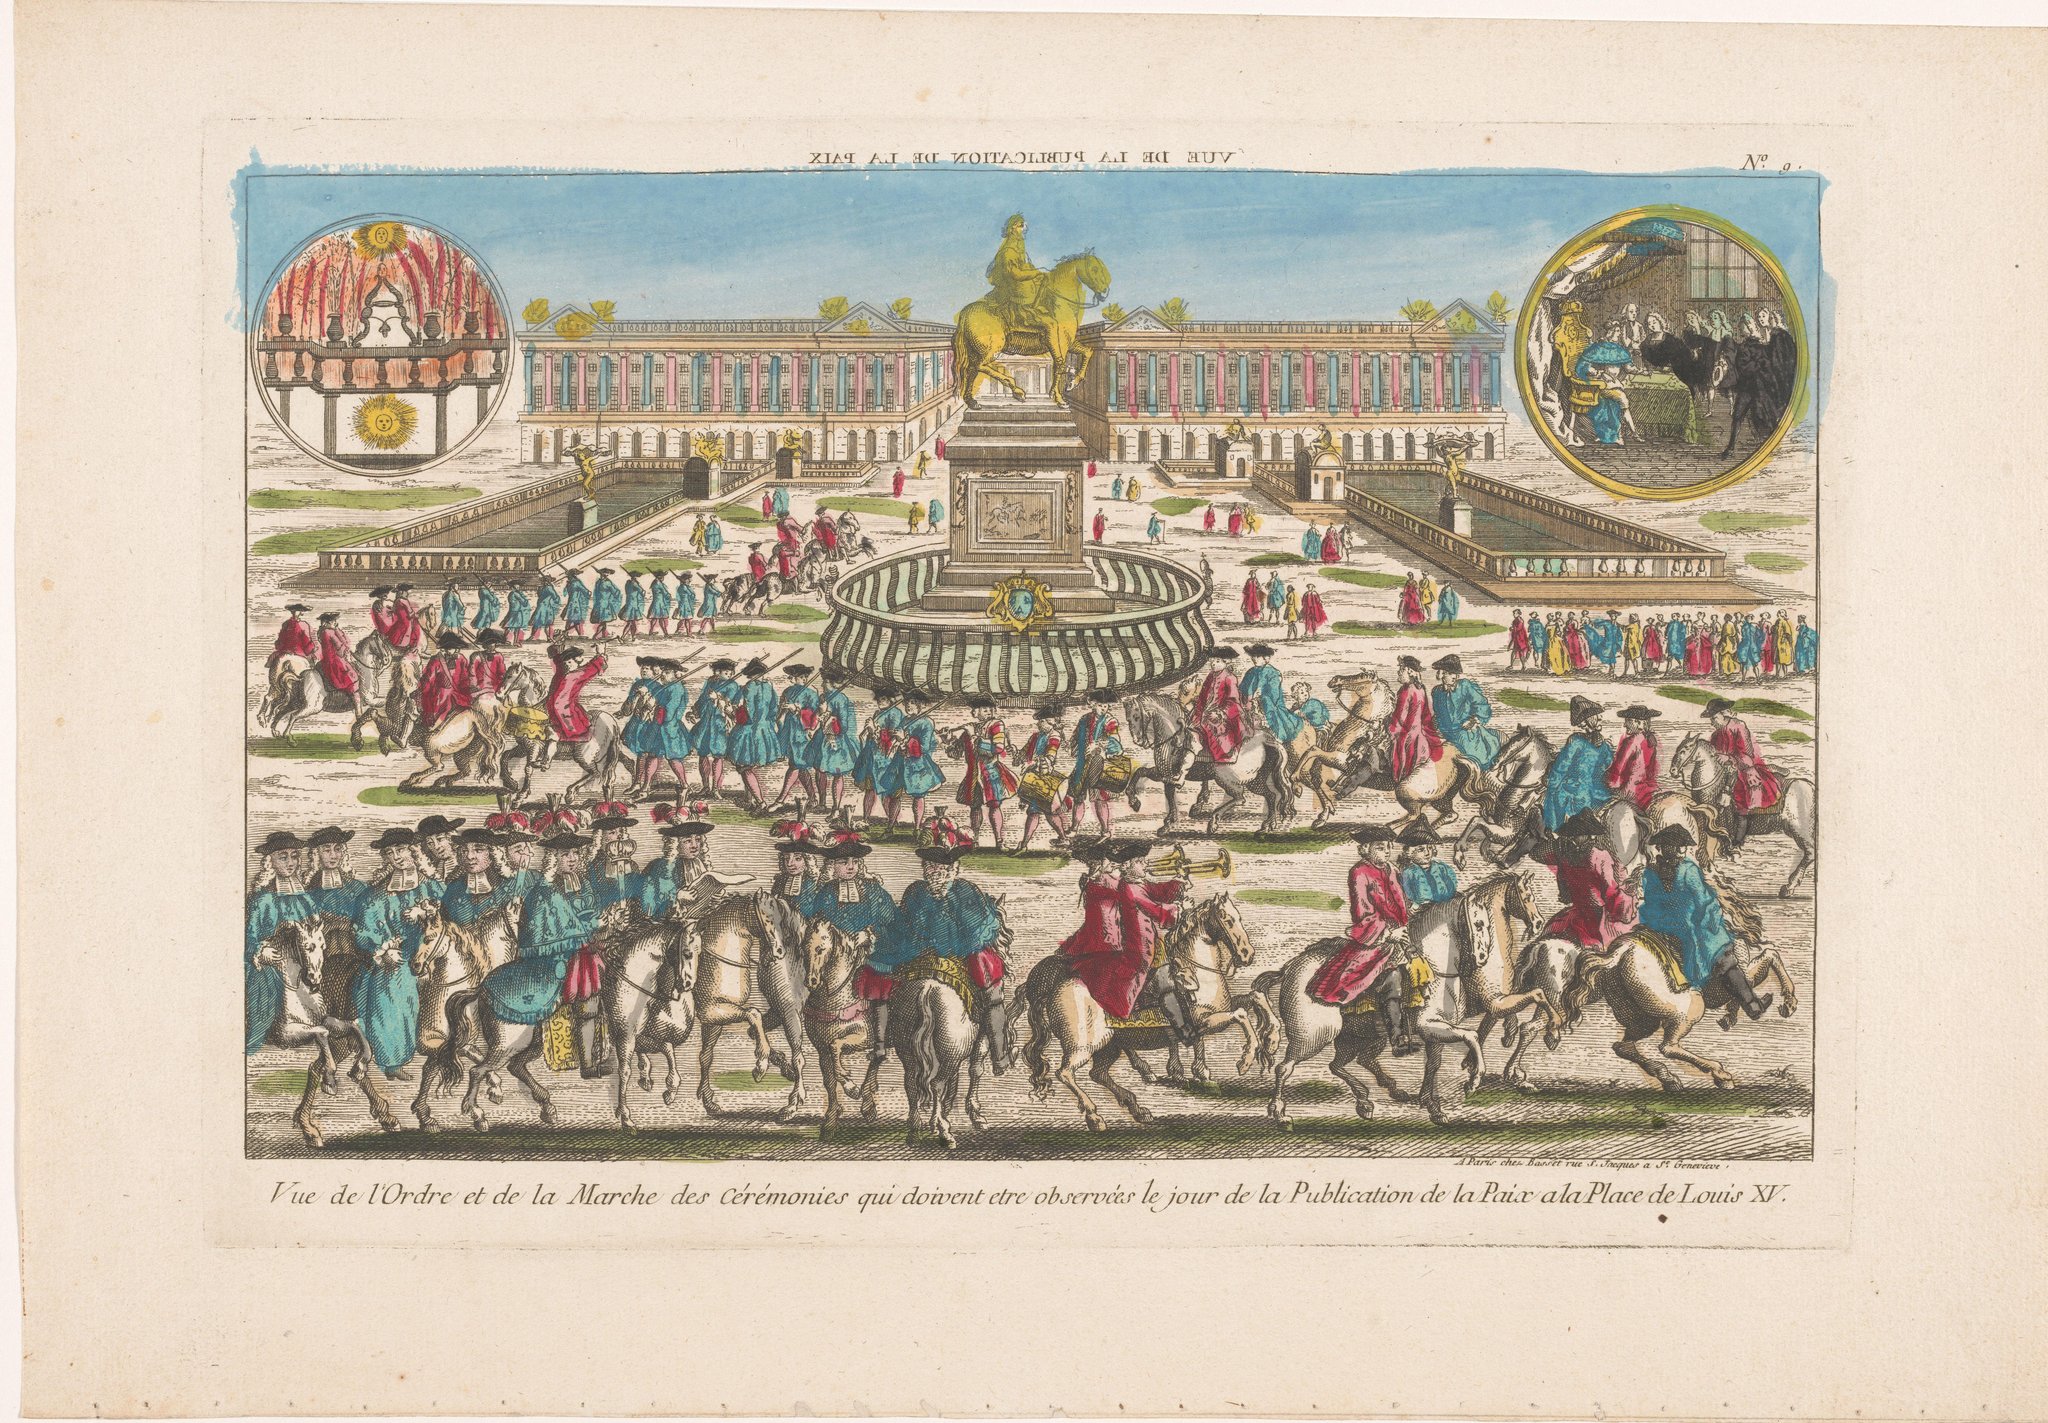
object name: print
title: Gezicht op de Place de Louis XV te Parijs met een stoet ter afkondiging van de vrede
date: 1700-1799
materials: paper, watercolor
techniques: brush, etching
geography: france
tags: proclamation of peace, military parade, pageant, equestrian statue, bonfire, fire-works, signing of peace treaty, concluding the peace, square, place, circus, etc. (+ city(-scape) with figures, staffage)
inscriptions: collector's mark: Lugt 2166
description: Rechtsboven tekent de koning het document. Linksboven wordt vuurwerk afgestoken. Genummerd: 9.